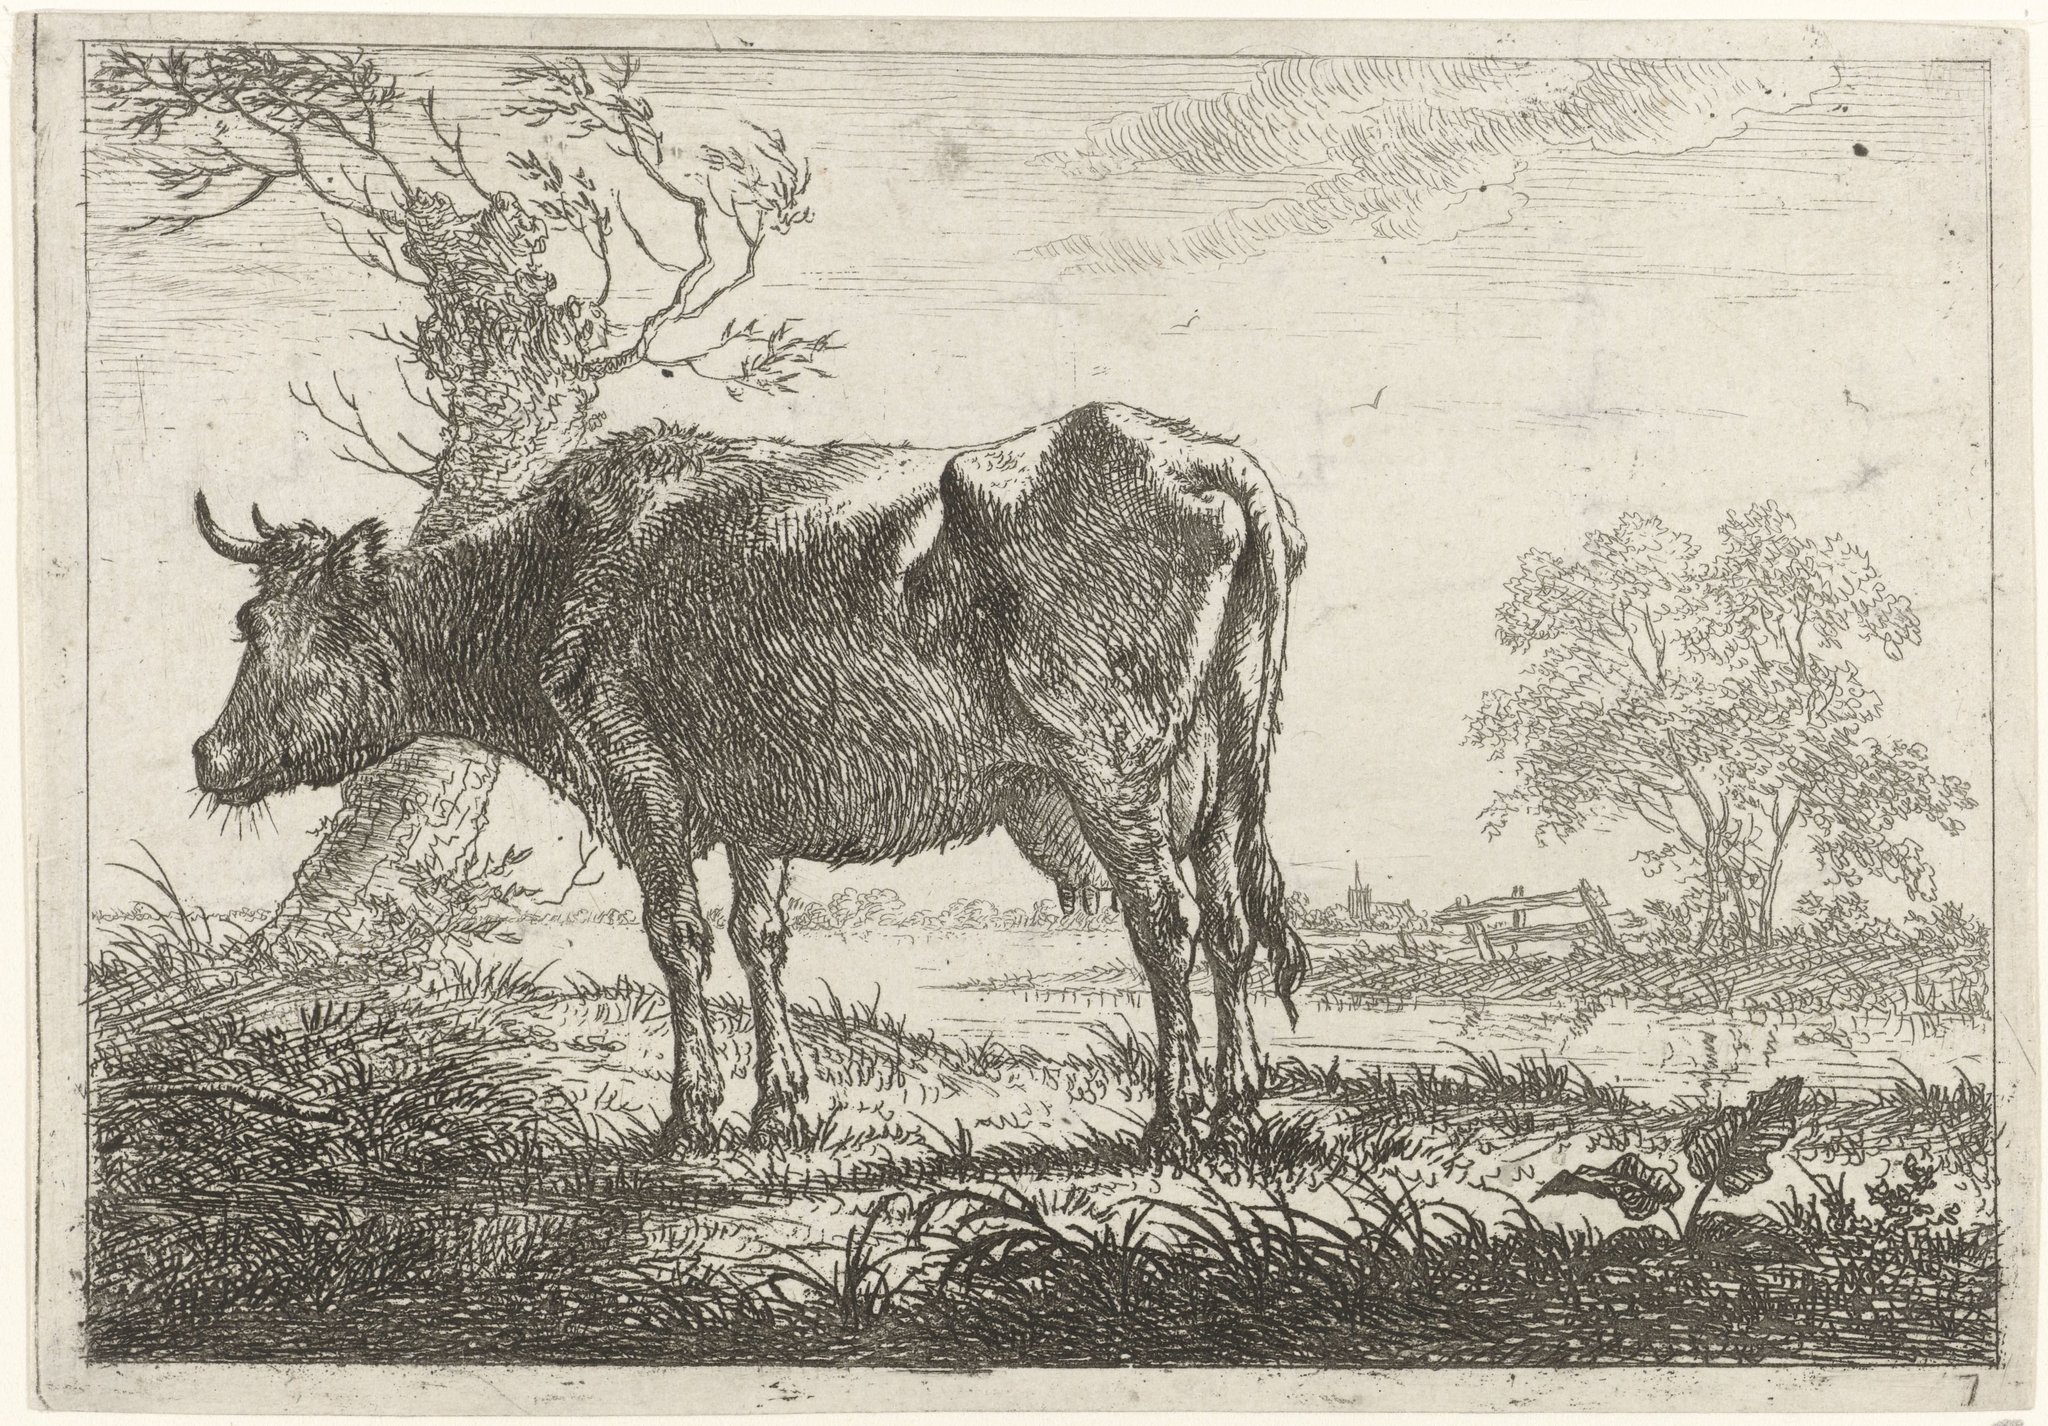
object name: print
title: Landschappen met vee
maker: johannes janson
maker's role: draughtsman, painter, print maker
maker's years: 1729-1784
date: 1761-1784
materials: paper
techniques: etching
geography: leiden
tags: cow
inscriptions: collector's mark: Lugt 2228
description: Weiland met staande koe, van opzij gezien. Links een tak. Zevende prent uit een serie van acht met landschappen met vee.